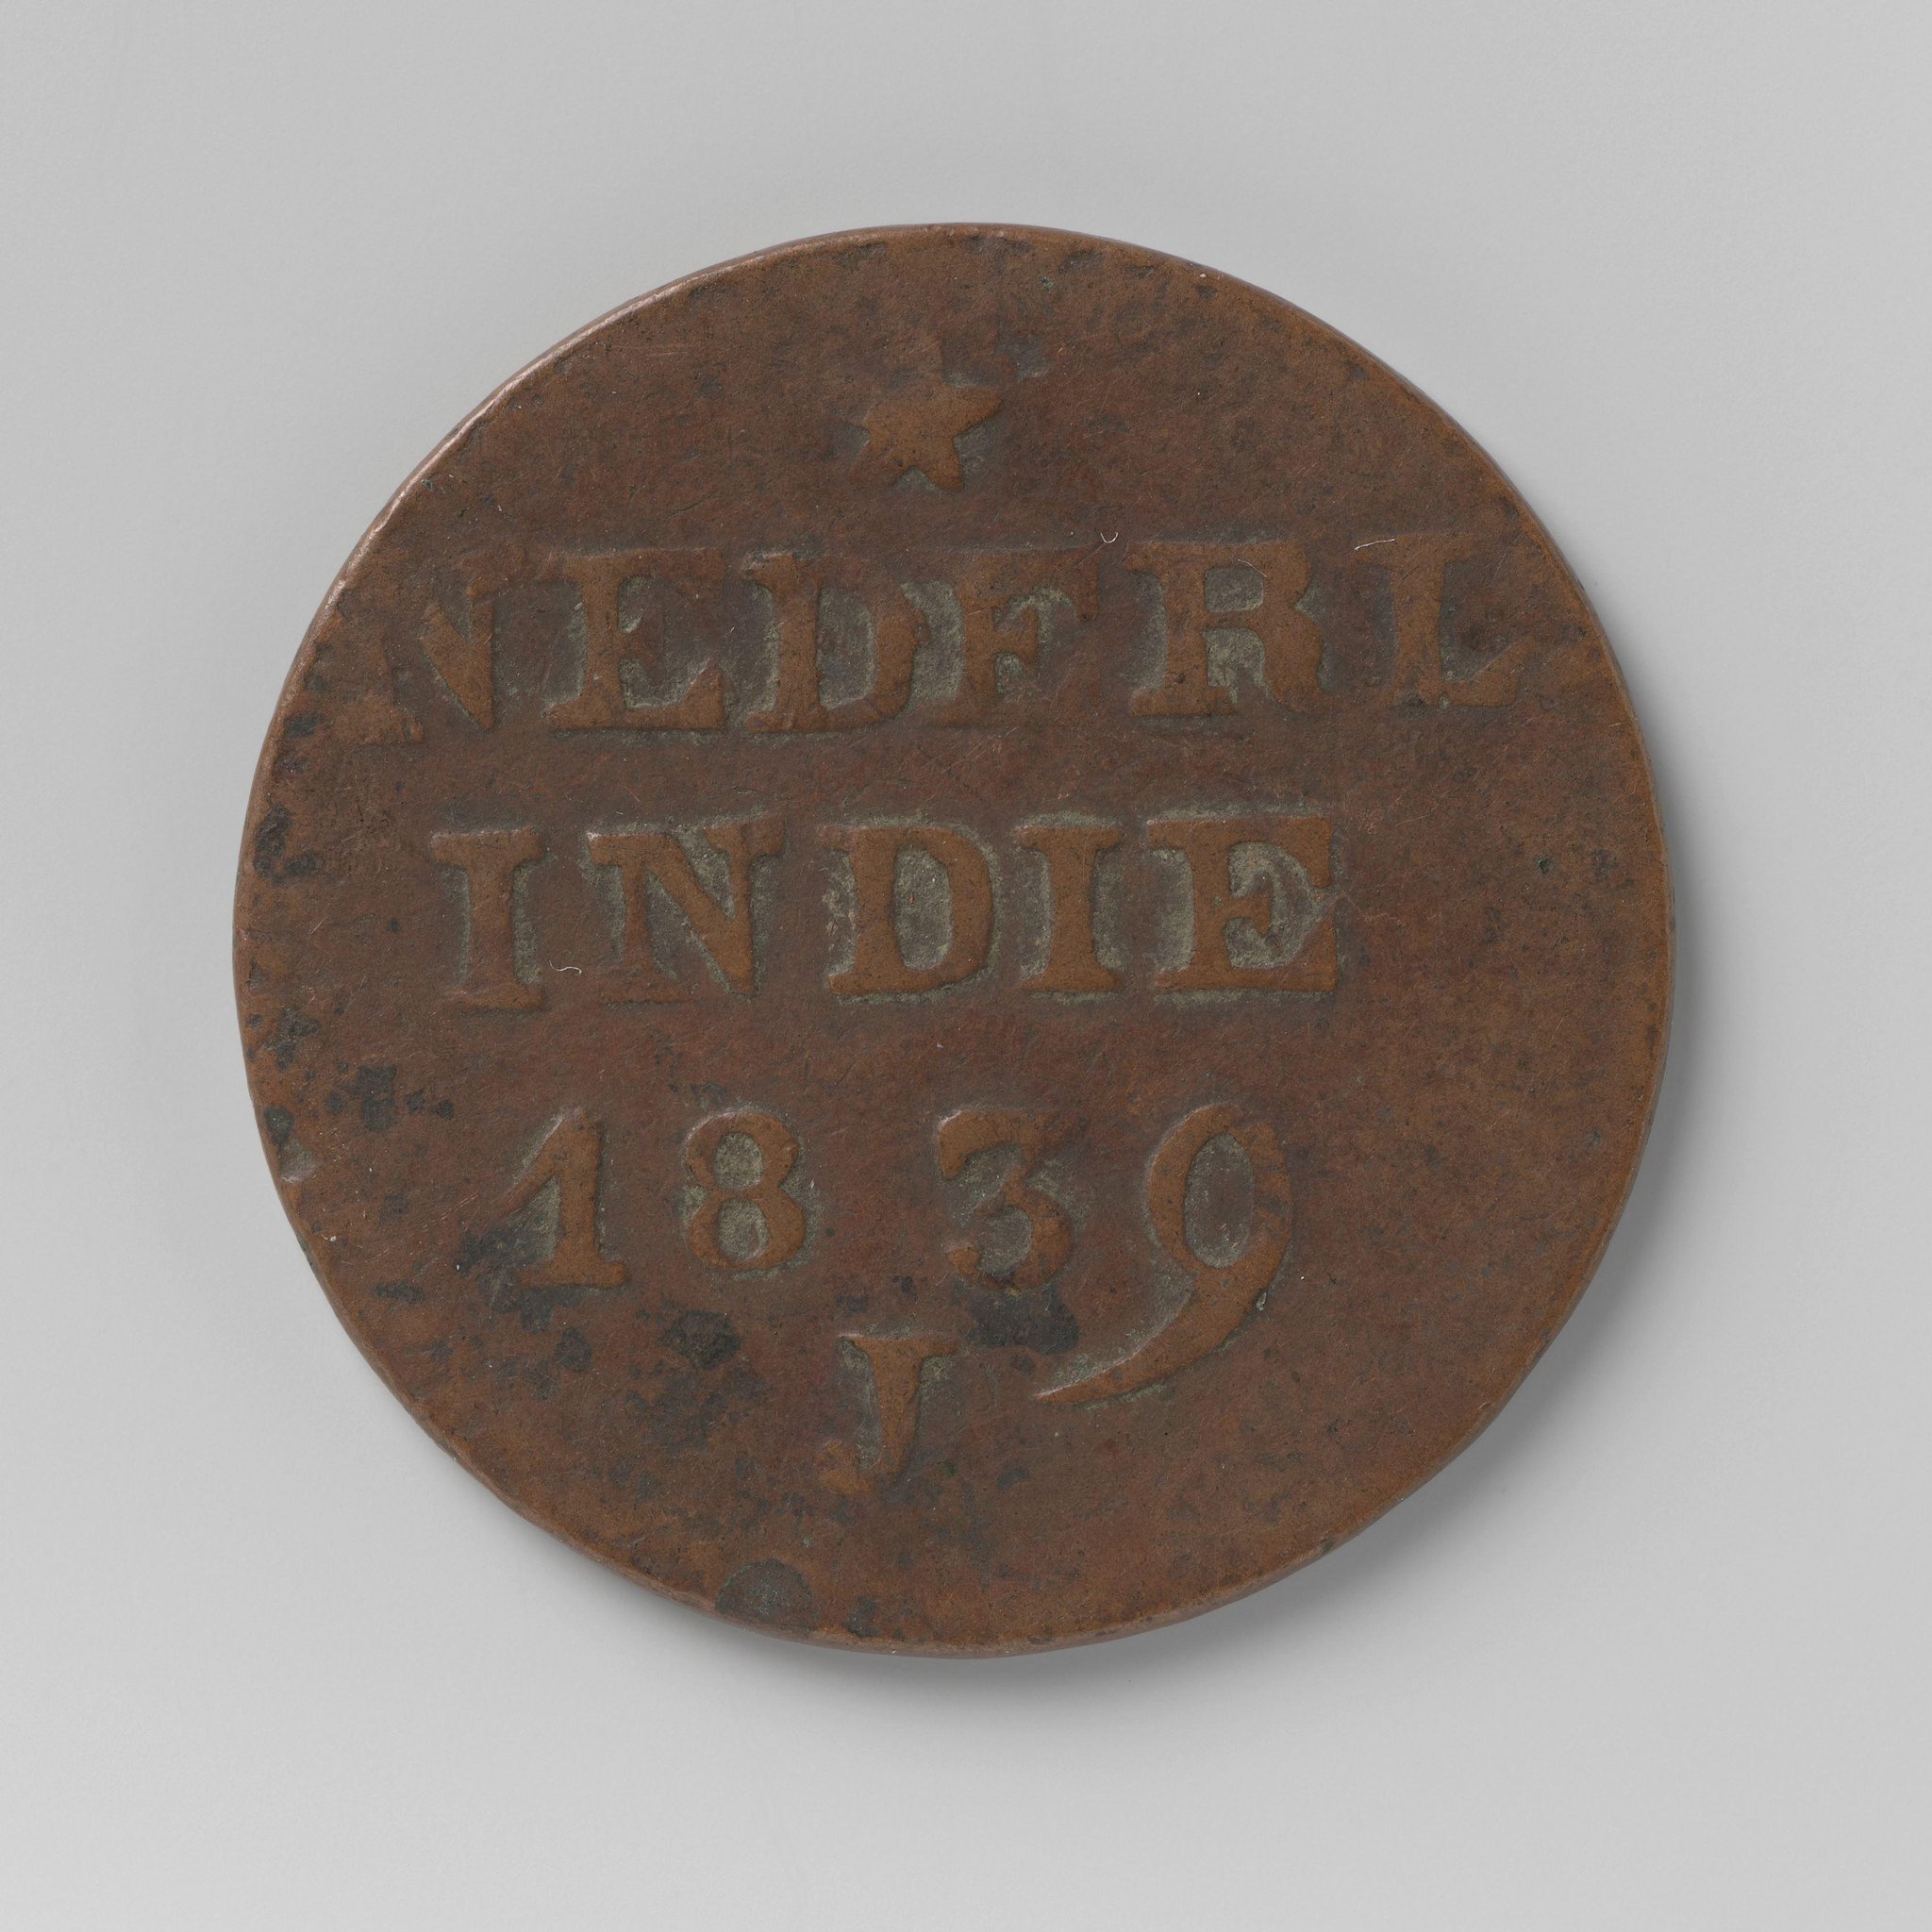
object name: coin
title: 2 cent van Nederlands Indië,1839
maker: william i of the netherlands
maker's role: koning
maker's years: 1772-1843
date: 1839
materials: copper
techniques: striking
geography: surabaya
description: Koperen munt. Voorzijde: tussen waarde-aanduiding 2 CT. gekroond rijkswapenschild. Keerzijde: tweeregelig opschrift, waarboven muntteken en waaronder jaartal. Daaronder letter J [=muntmeester Jeekel]. Gladde rand.